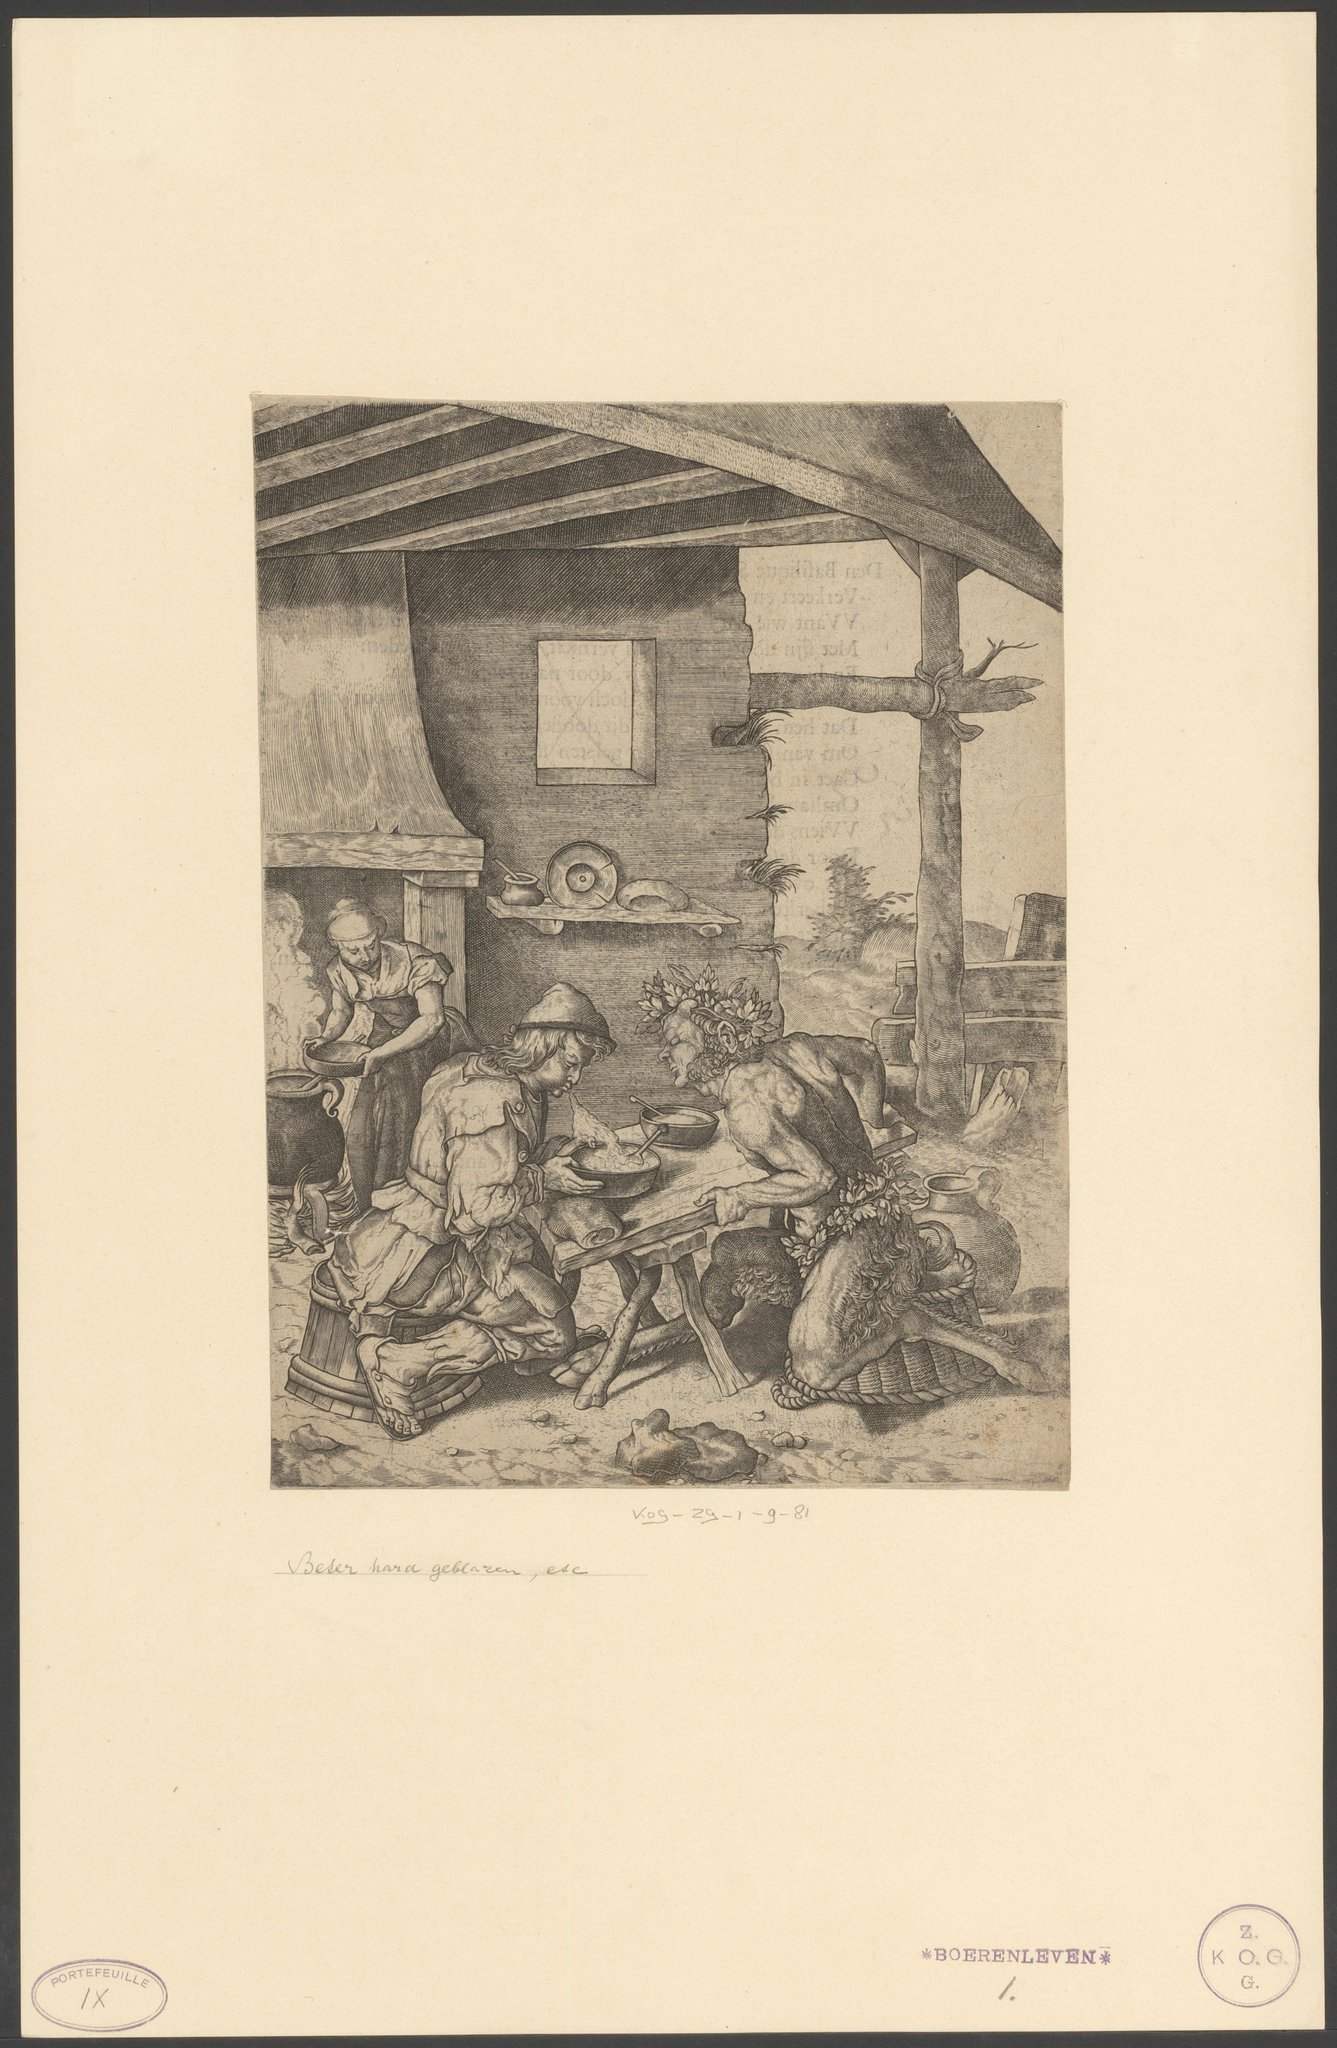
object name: print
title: Fabel van de boer en de sater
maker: Anonymous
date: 1617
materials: paper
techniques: engraving, letterpress printing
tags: the satyr and the peasants; according to aesop: the satyrs and the peasant (meal, blowing to cool food, etc.)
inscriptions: stamp, stamp, collector's mark: Lugt 1641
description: Een boer en een sater aan een tafel in een huis. De sater kijkt geboeid naar de boer die in zijn soep blaast. De fabel beschrijft hoe een sater te gast is bij een boer. De boer blaast eerst in zijn verkleumde handen en daarna in zijn kom soep. De sater is verbaasd dat de boer uit eigen mond zowel warmte als kou kan blazen en beschouwt hem als een tovenaar. Onderwerpsrubrieken binnen de Atlas Zeden en Gewoonten: Handel, nijverheid en verkeer, Boerenleven.